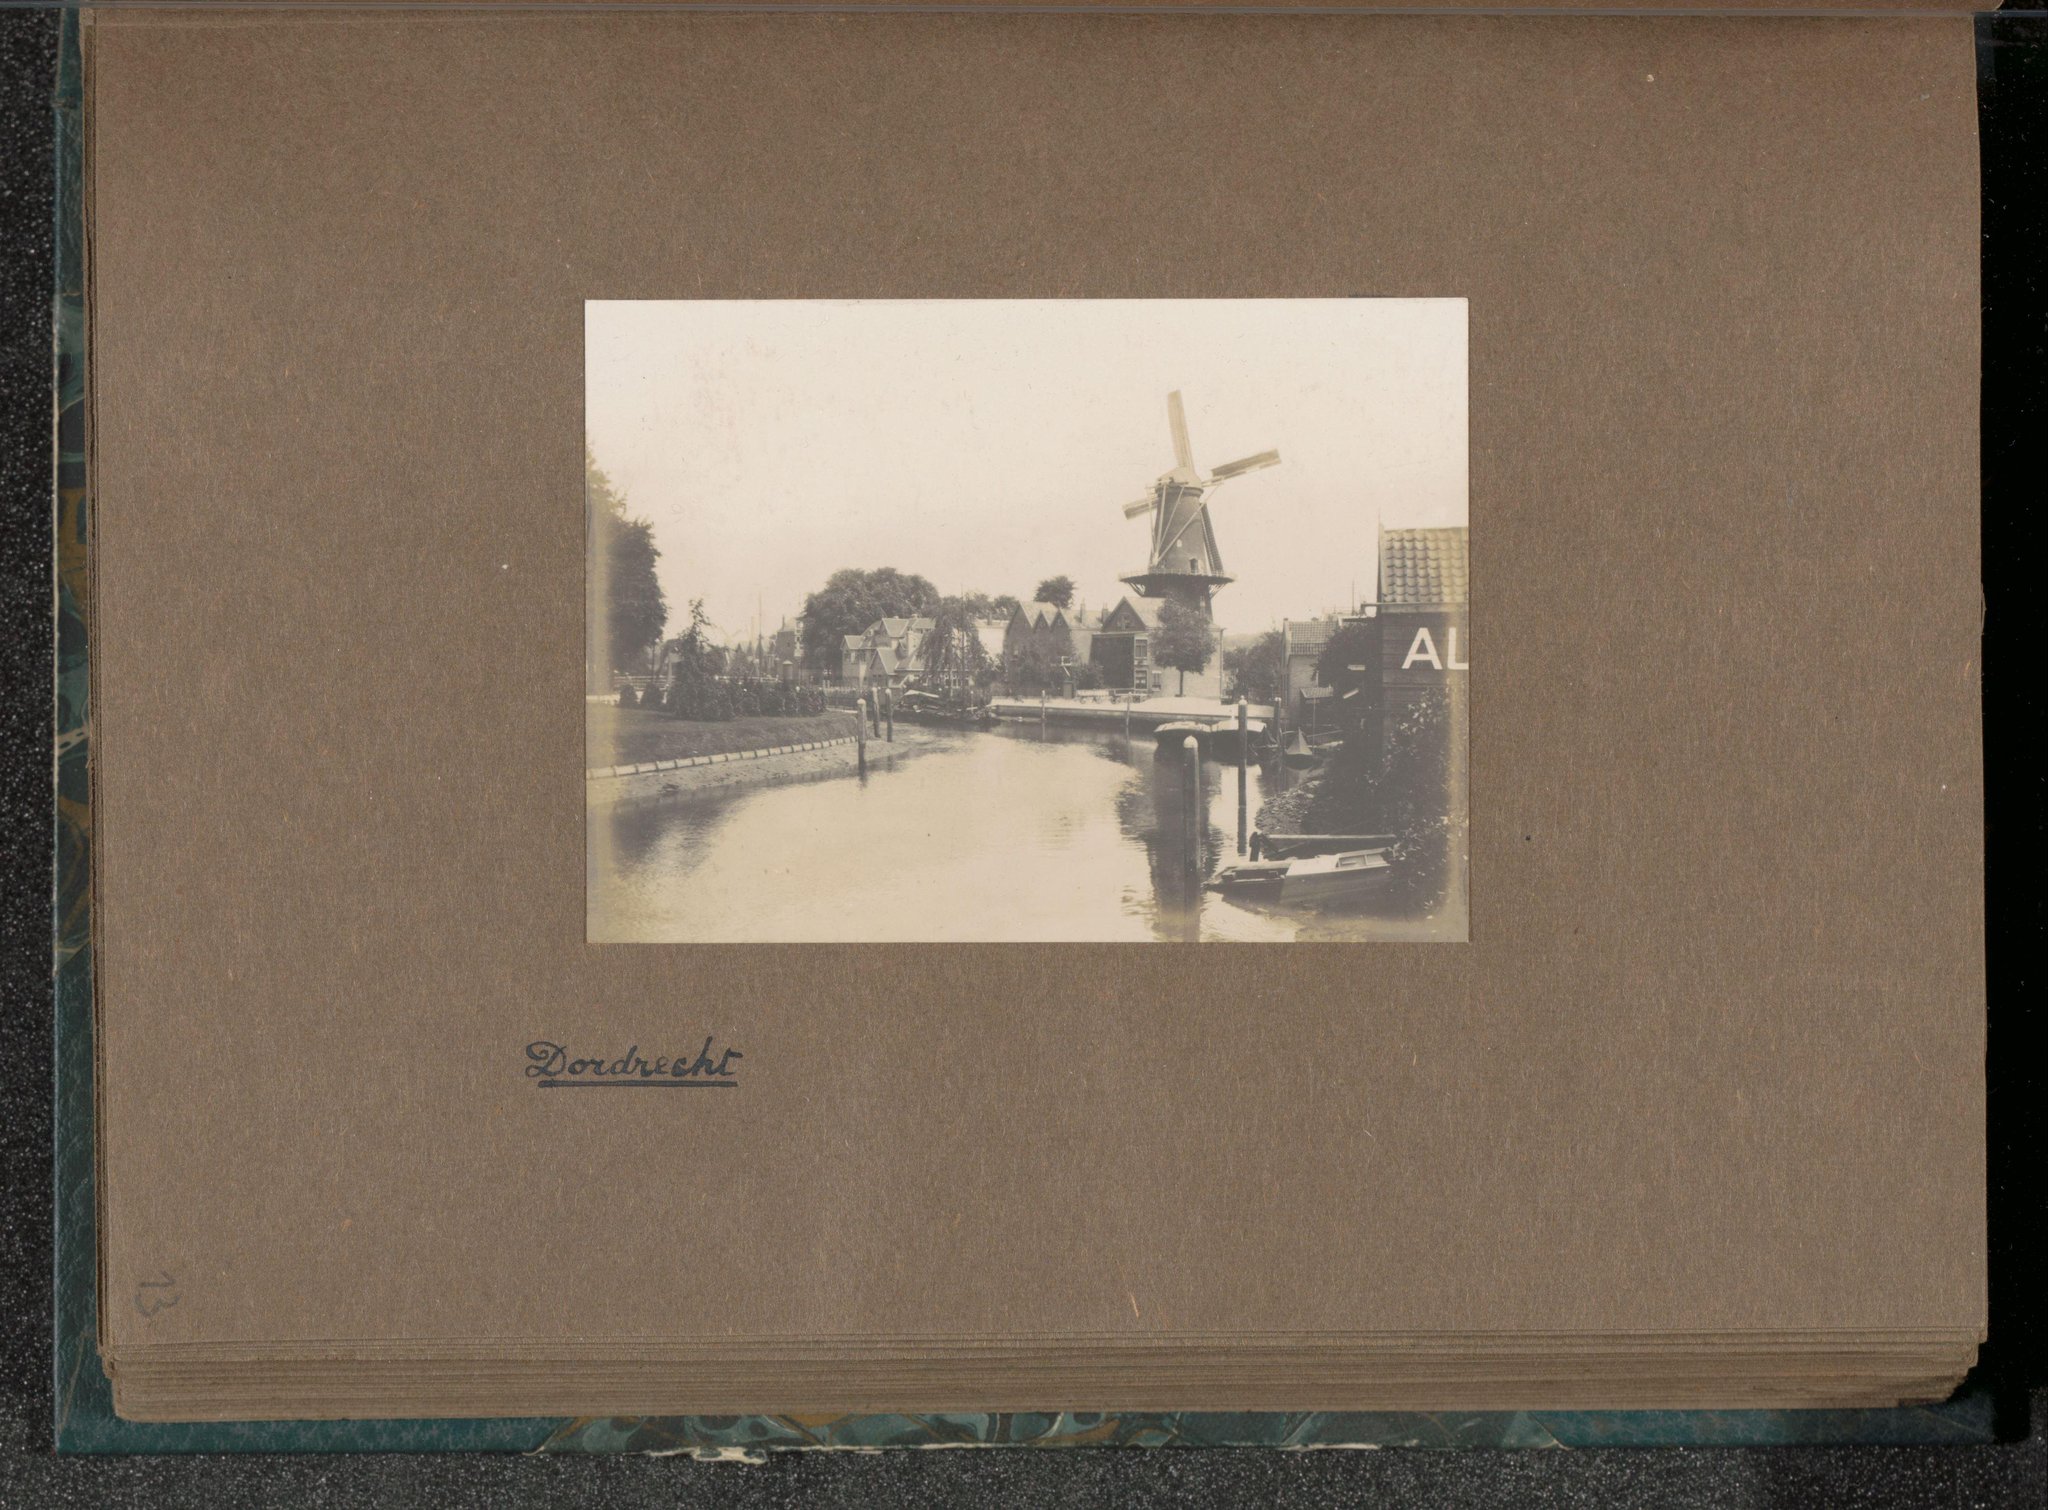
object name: photograph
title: Spuihaven met windmolen 'De Maagd' gezien vanaf de Vest in Dordrecht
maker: Anonymous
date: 1912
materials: photographic support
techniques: gelatin silver print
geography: dordrecht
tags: canal, windmill in landscape, travelling; tourism, dordrecht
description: Onderdeel van Fotoalbum van de excursie naar Nederland van de Britse amateurfotografenvereniging P.C.U.K.